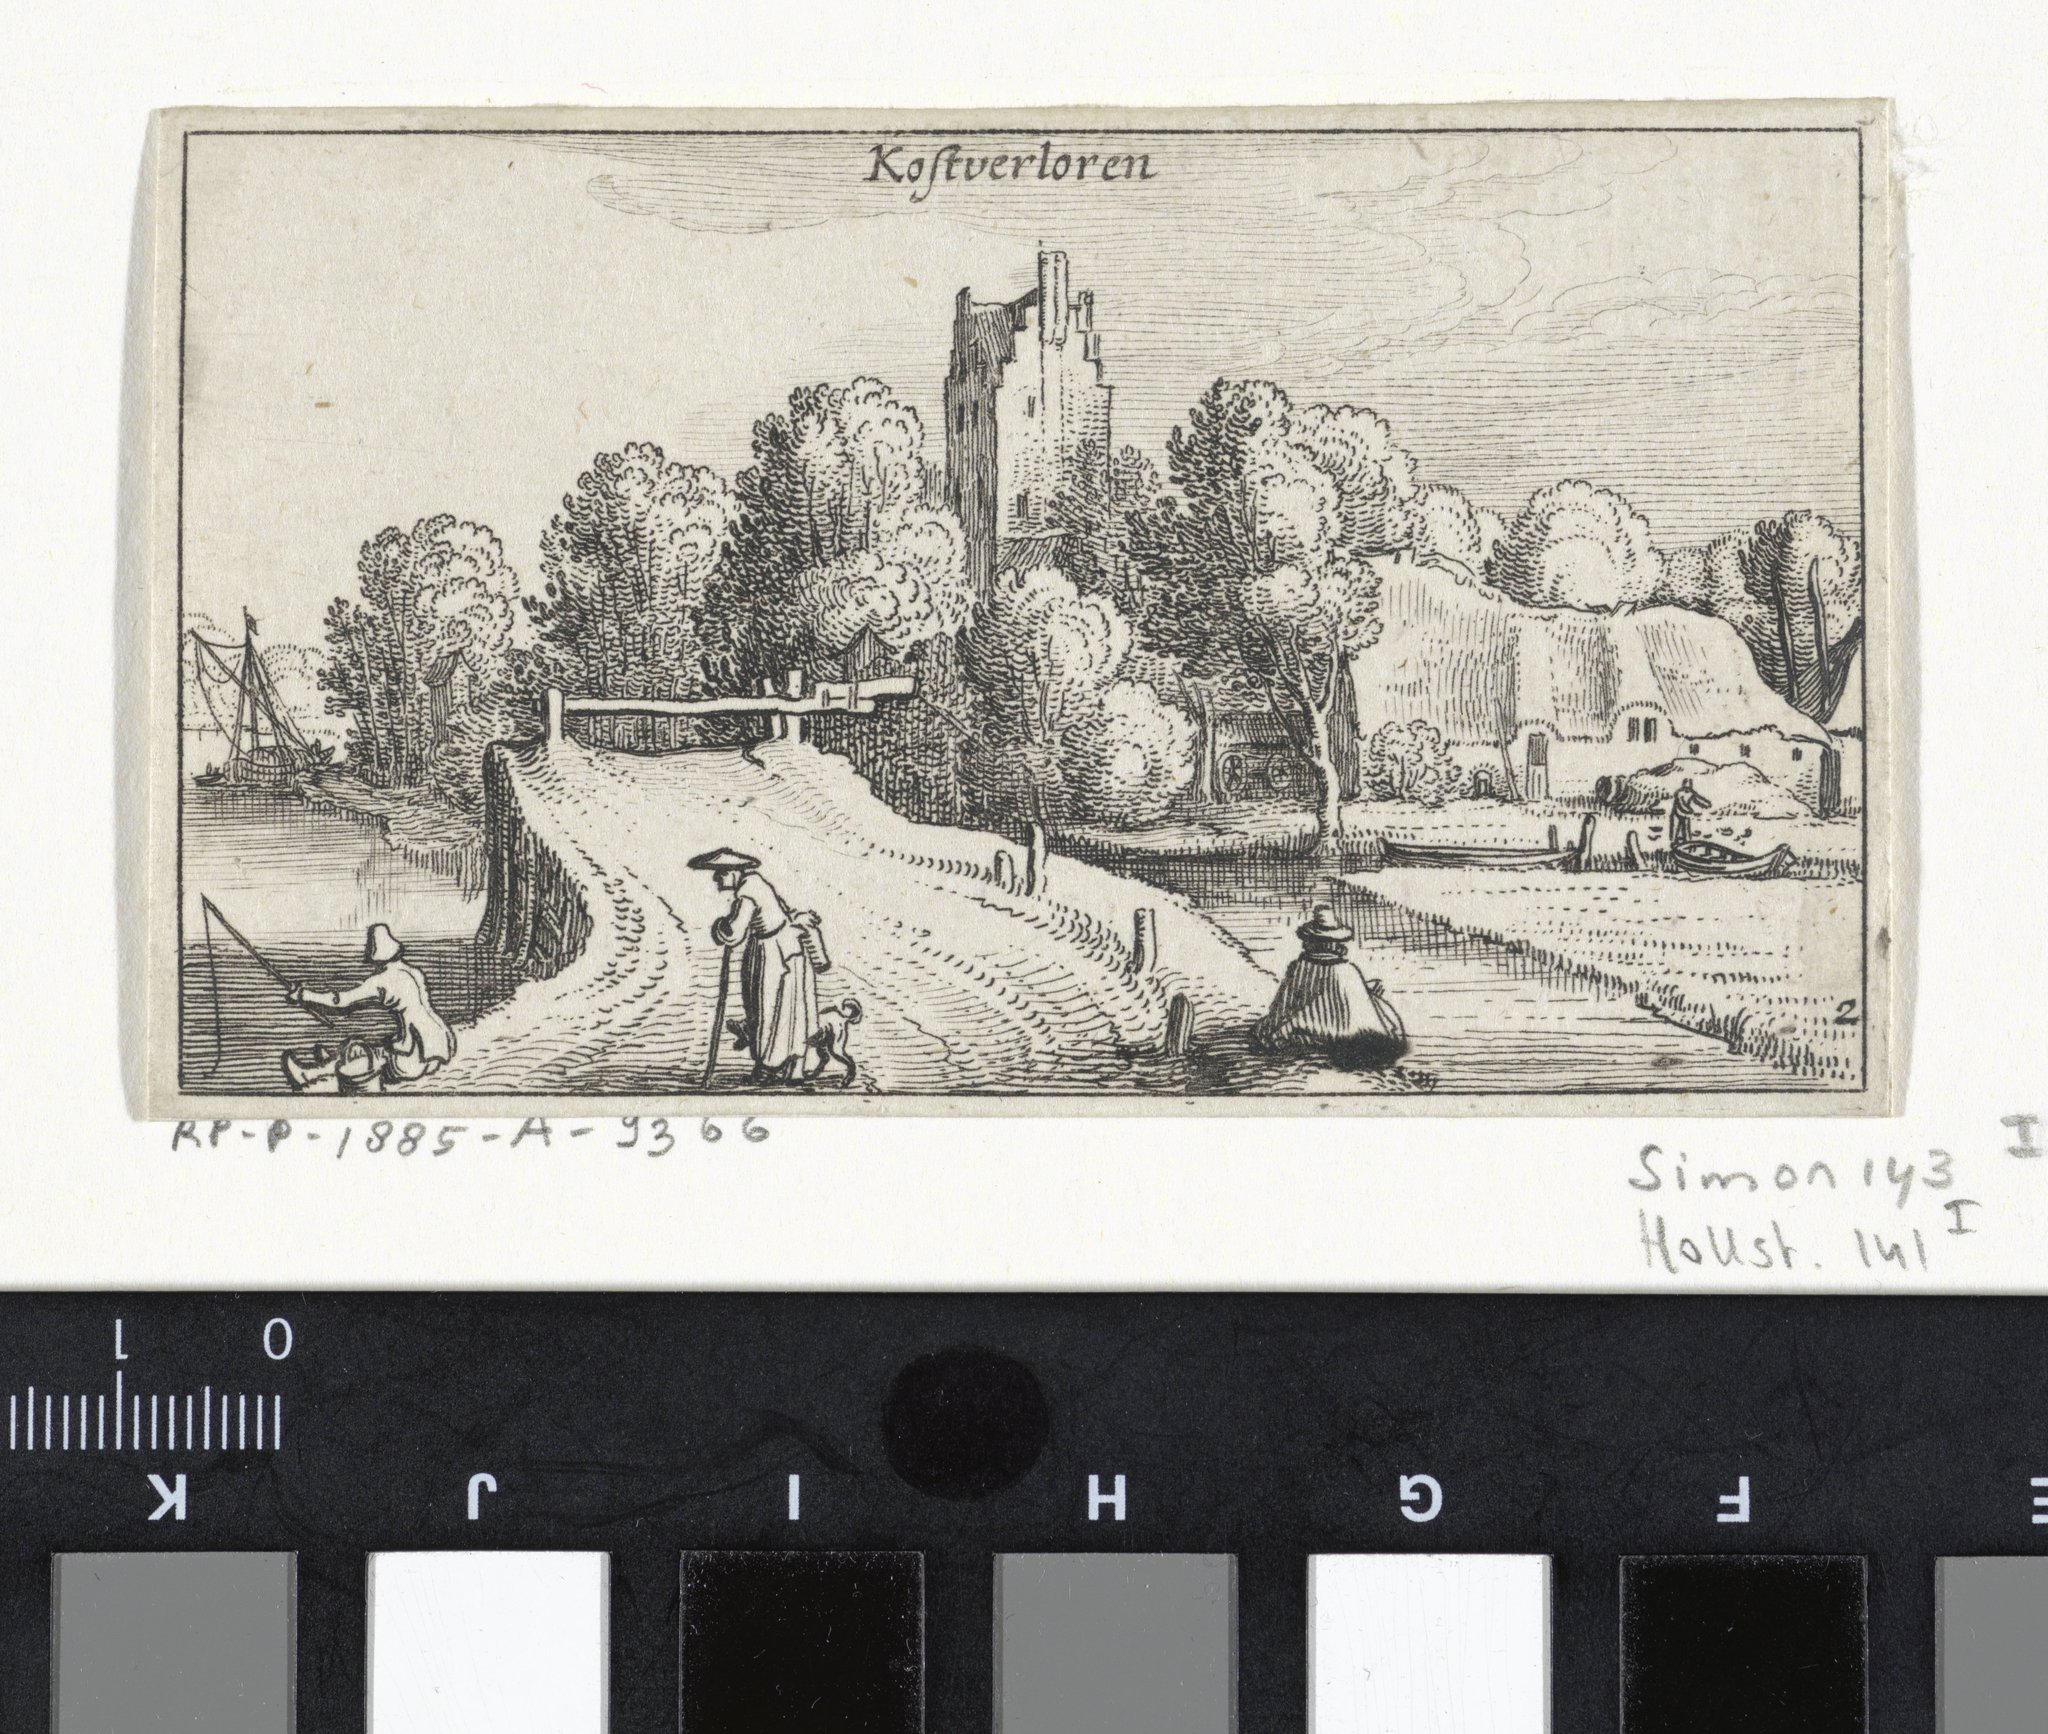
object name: print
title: Huis Kostverloren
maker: claes jansz. visscher (ii)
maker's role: draughtsman, print maker, publisher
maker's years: 1586-1652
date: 1612-1652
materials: paper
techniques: etching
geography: amsterdam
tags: landscapes, villa, fisherman, dog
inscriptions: number: ‘2’, title: ‘Kostverloren’, collector's mark: Lugt 2228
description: Gezicht op Huis Kostverloren nabij Amsterdam, waarnaast een lage boerderij. Op de voorgrond een visser en een vrouw, leunend op haar stok, met een hond. Rechts zit een figuur aan de waterkant.